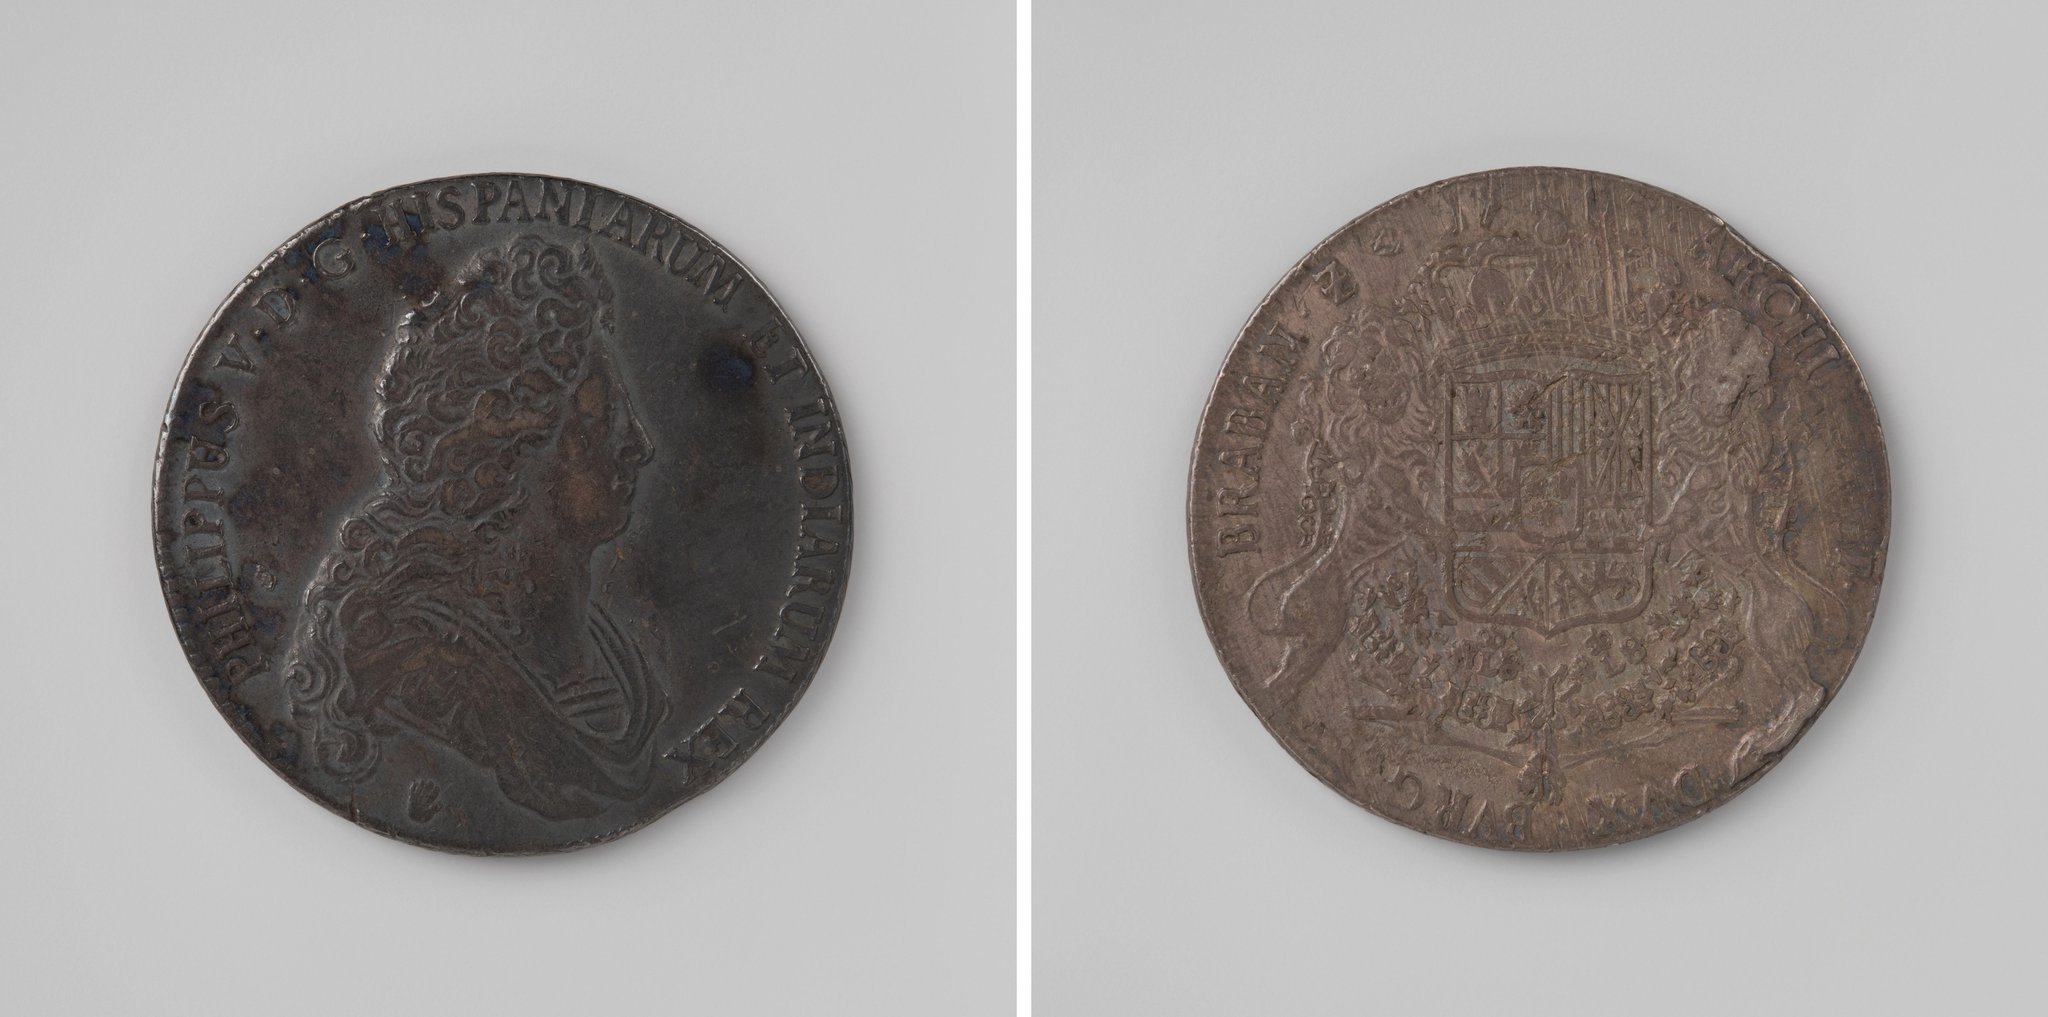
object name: ducatoon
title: Filips V, koning van Spanje, hertog van Brabant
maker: Anonymous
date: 1703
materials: silver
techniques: striking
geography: antwerp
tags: filips v (koning van spanje), brabant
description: Voorzijde: borststuk man binnen omschrift. Keerzijde: gekroond wapenschild, omhangen met de orde van het Gulden Vlies en de orde van de H. Geest, geflankeerd door twee leeuwen binnen omschrift